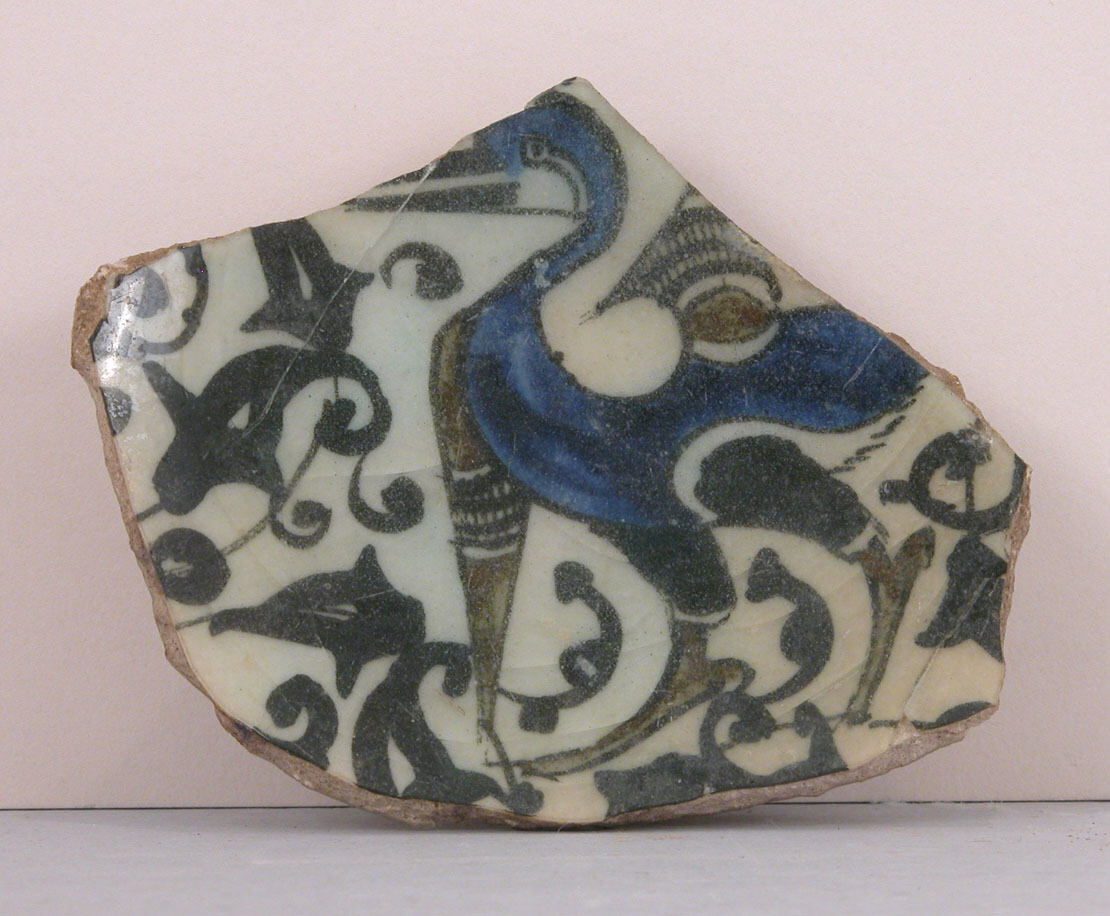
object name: fragment of a bowl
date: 1201-1600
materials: glaze, stonepaste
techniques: painting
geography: egypt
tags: birds